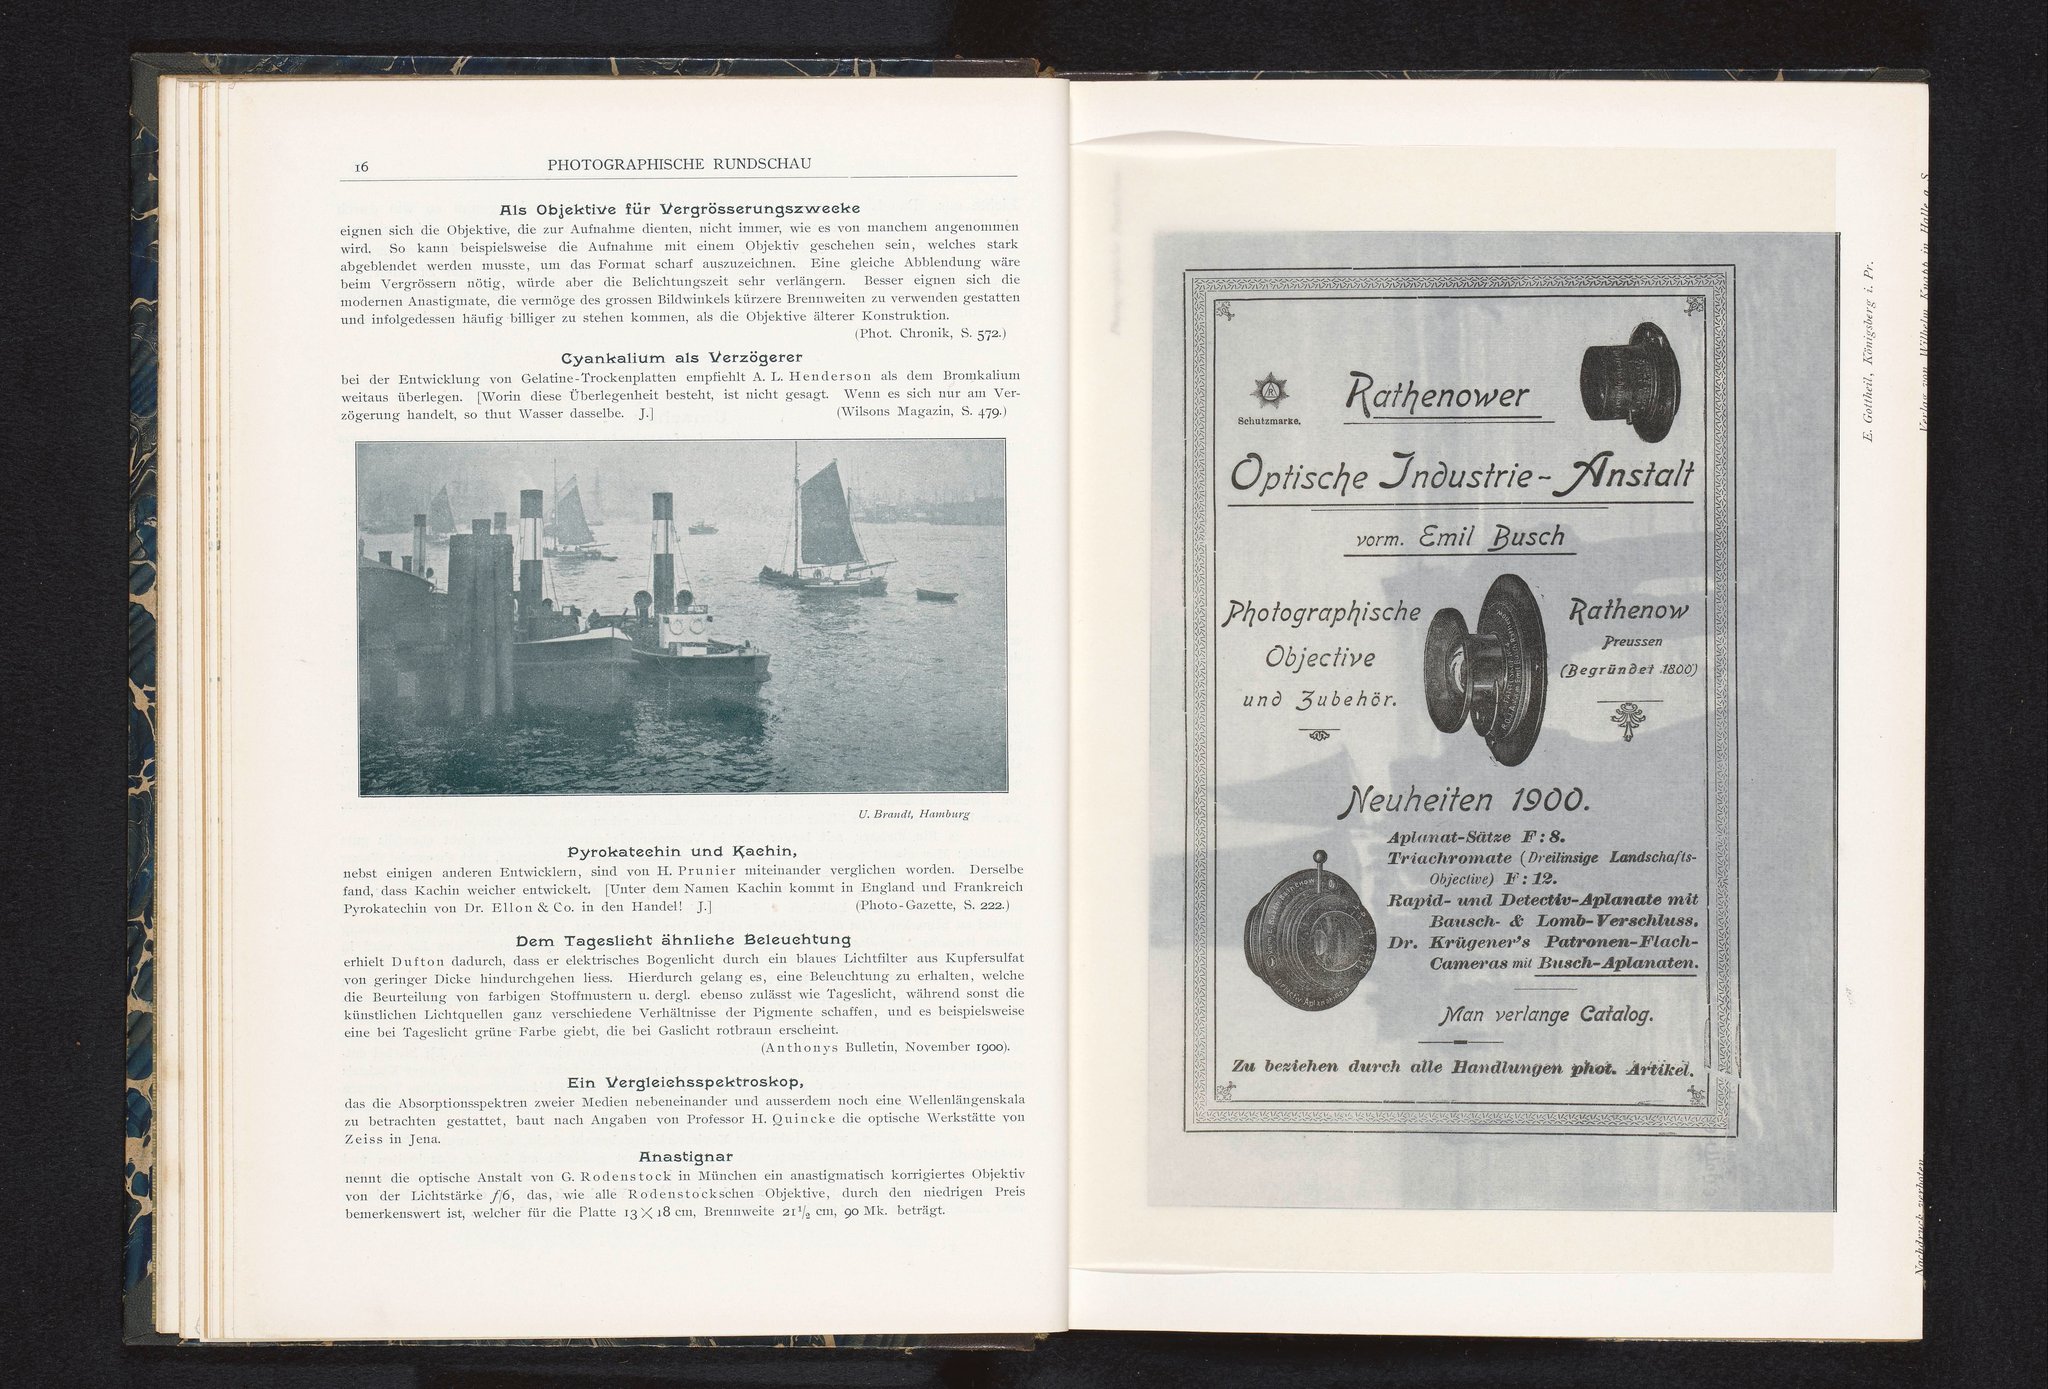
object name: photomechanical print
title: Schepen bij een haven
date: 1896-1901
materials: paper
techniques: autotype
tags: harbour